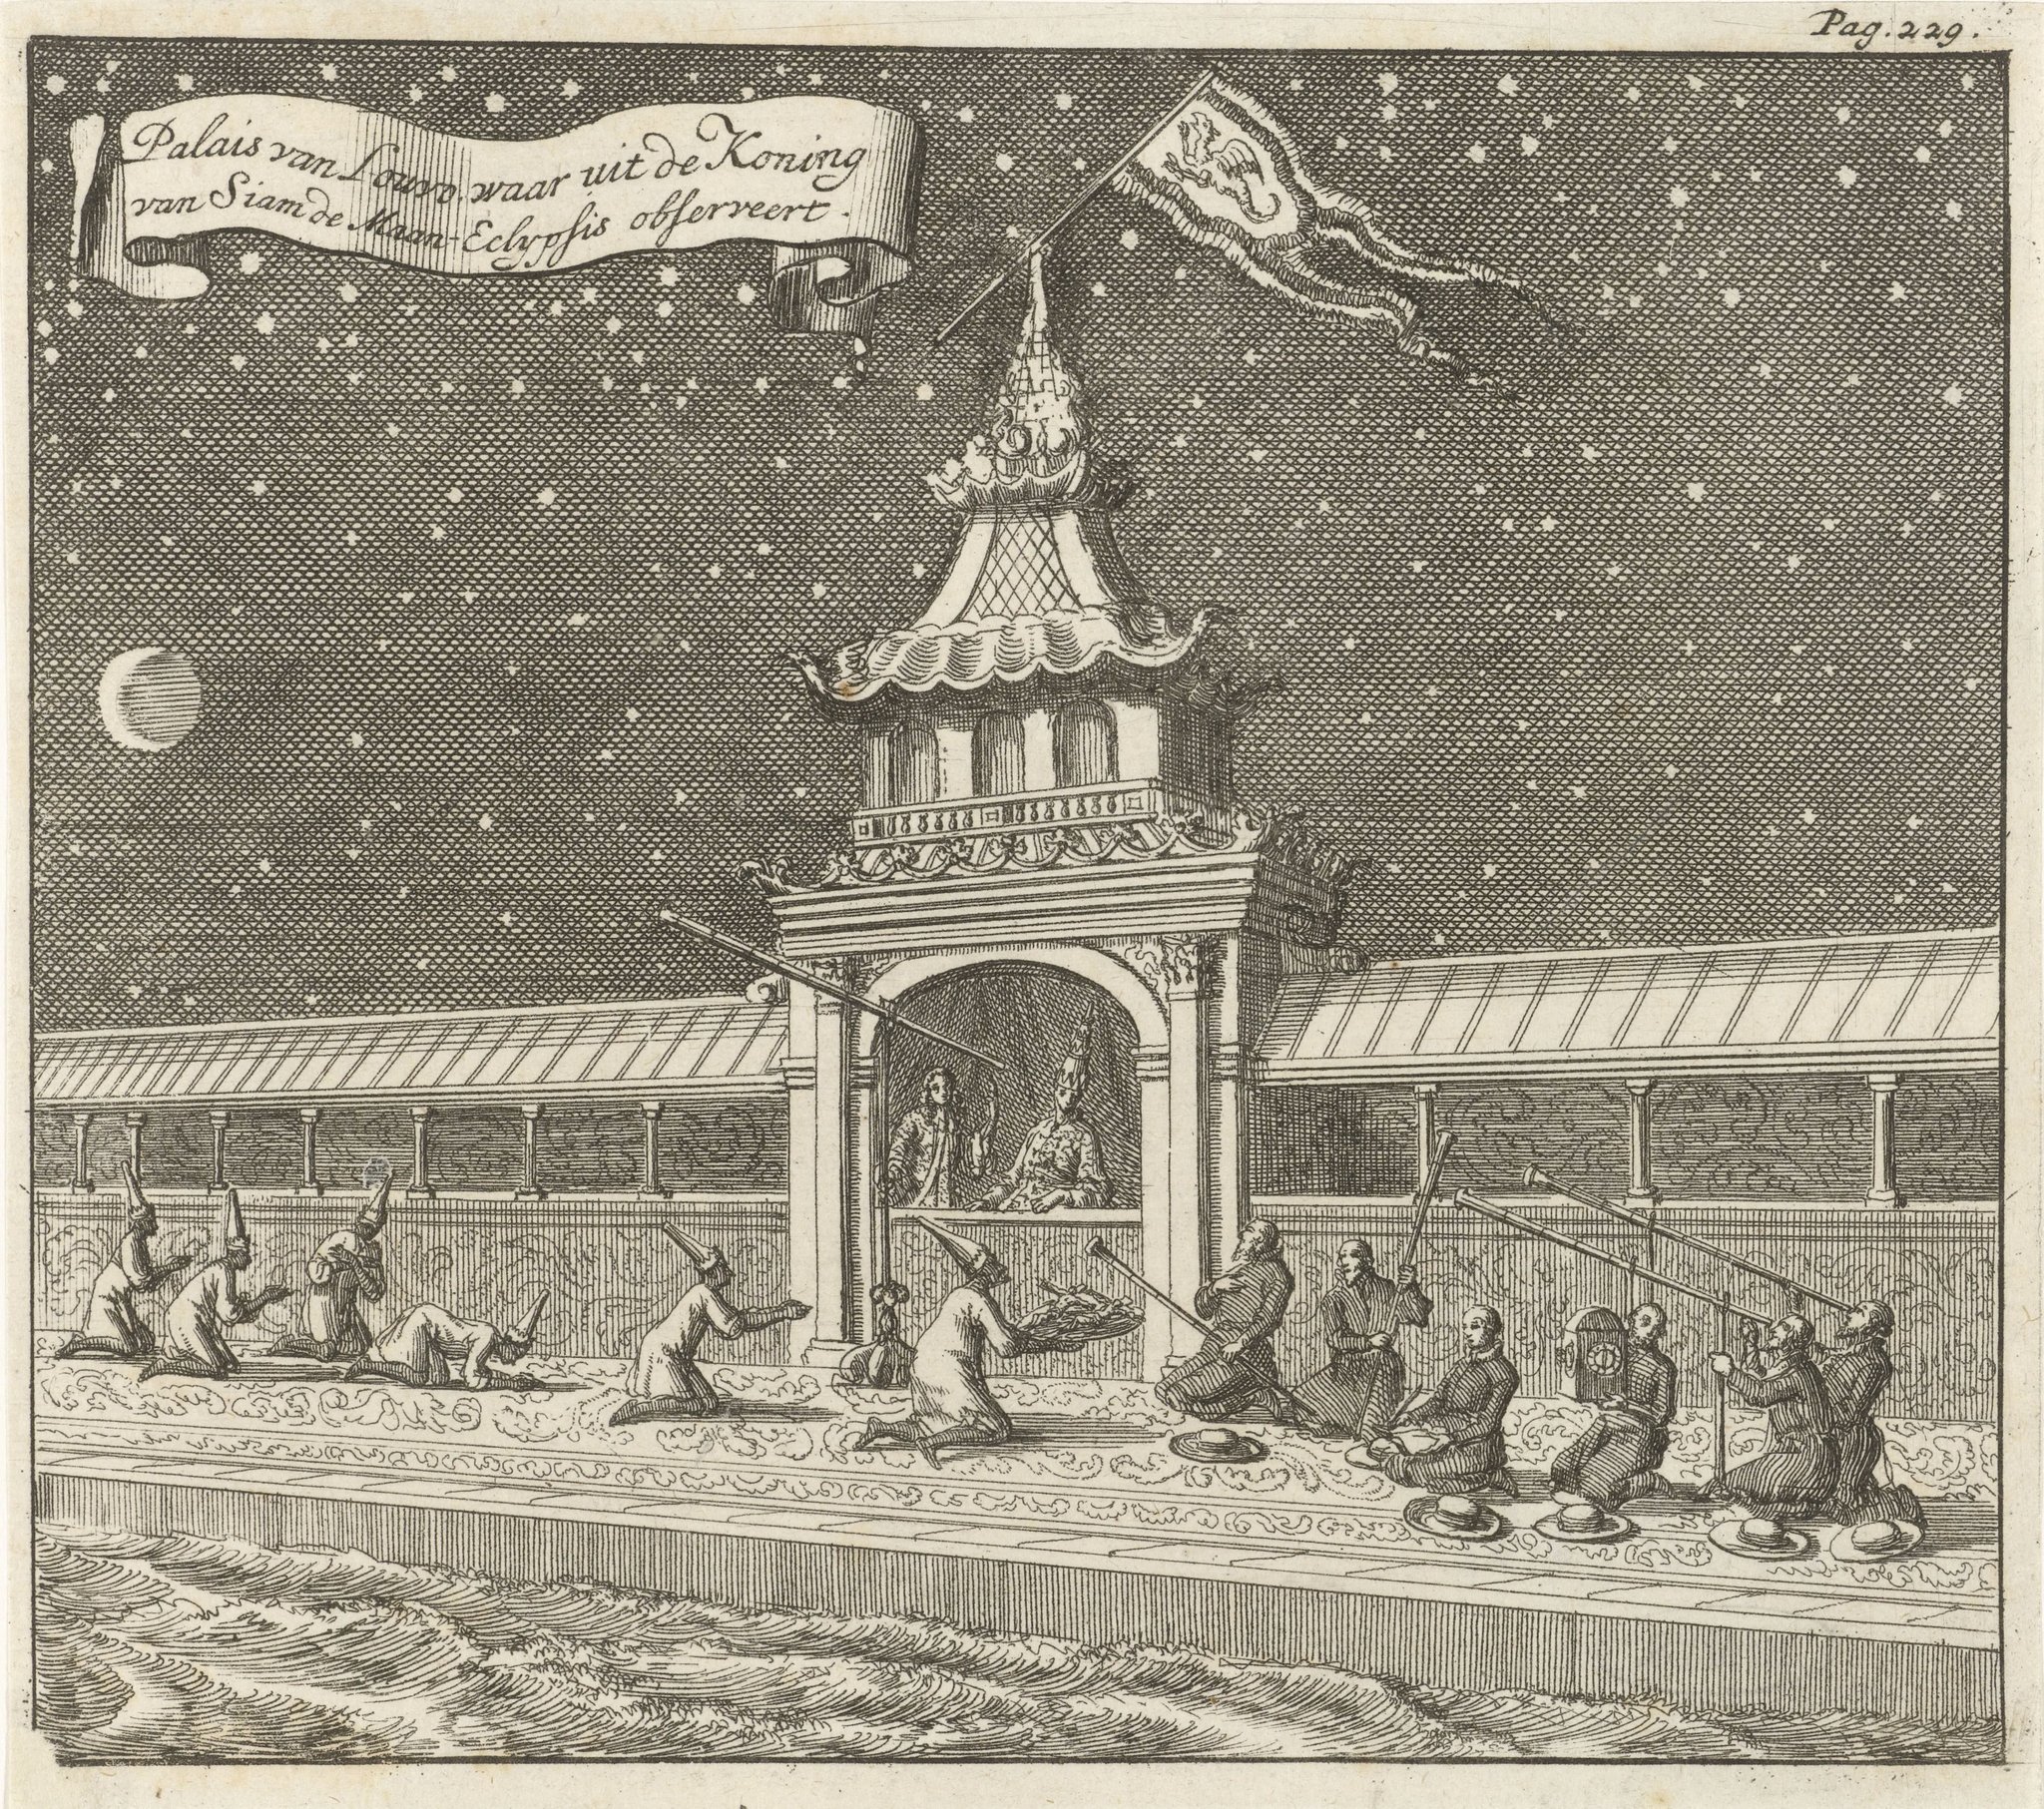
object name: book illustration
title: The King of Siam Observing the Lunar Eclipse from his Palace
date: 1687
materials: paper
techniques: etching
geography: amsterdam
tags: palace, eclipse of the moon, thailand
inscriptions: collector's mark: Lugt 2228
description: In the portrait Narai is presented as a ‘stereotypical’ oriental monarch. His likeness is therefore more of a European interpretation than a portrait of an individual. The print at the upper right illustrates the first French diplomatic visit to Siam. The observation of the lunar eclipse, lower right, took place on 11 December 1685. By introducing Narai to the latest developments in astronomy, the French Jesuits hoped to win him over to Catholicism.